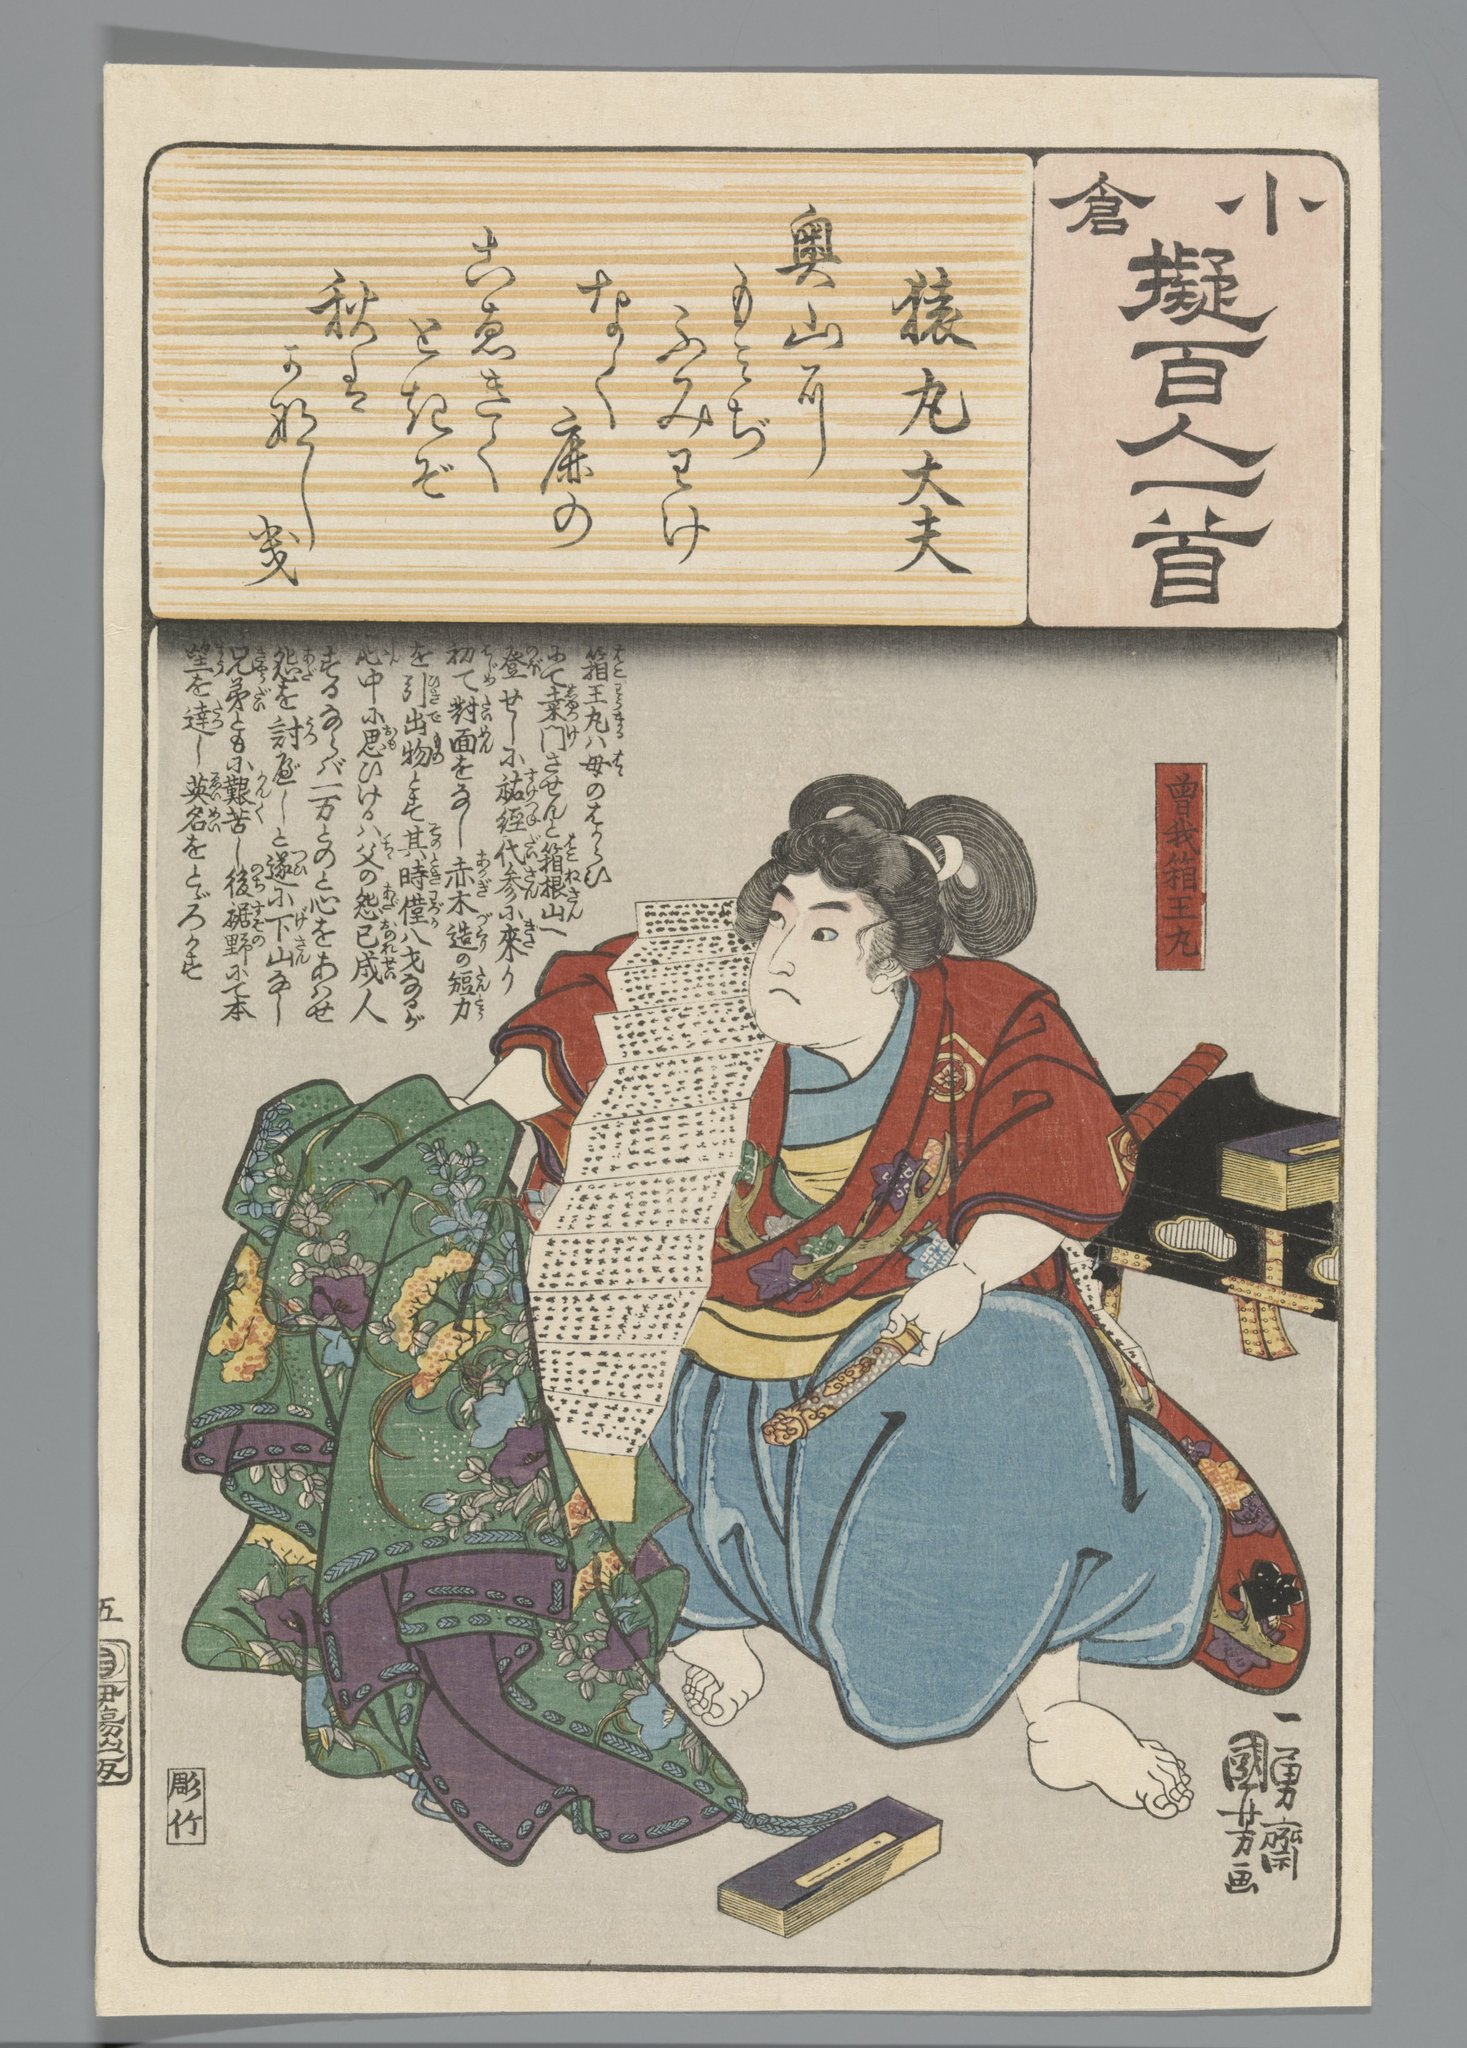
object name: print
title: Ogura Imitation of the One Hundred Poems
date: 1845-1846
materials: paper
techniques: woodcut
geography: japan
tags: scroll - ll - scroll unfolded, child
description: Soga Gorô als kind met manuscript over zijn schouder. Scene uit een kabukitoneelstuk. Gedicht door Sarumaru Dayû.